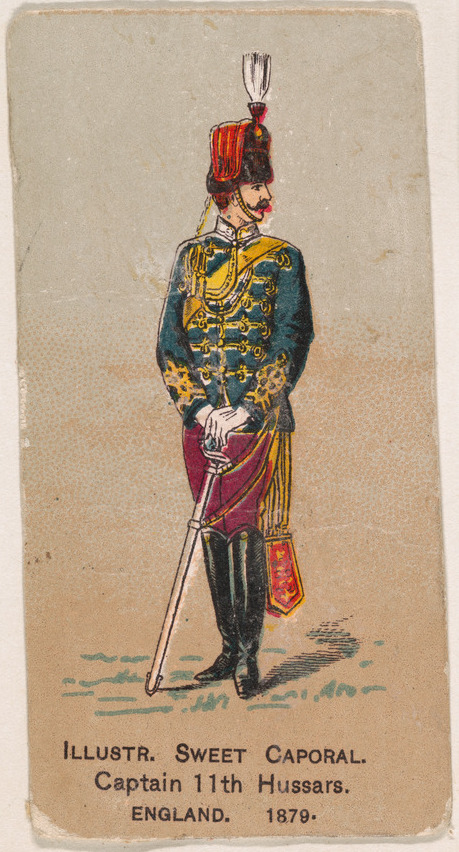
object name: print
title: Captain, 11th Hussars, England, 1879, from the Military Series (N224) issued by Kinney Tobacco Company to promote Sweet Caporal Cigarettes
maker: kinney brothers tobacco company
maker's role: publisher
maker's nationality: american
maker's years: 1869-2011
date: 1888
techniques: color lithograph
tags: military,men,profiles